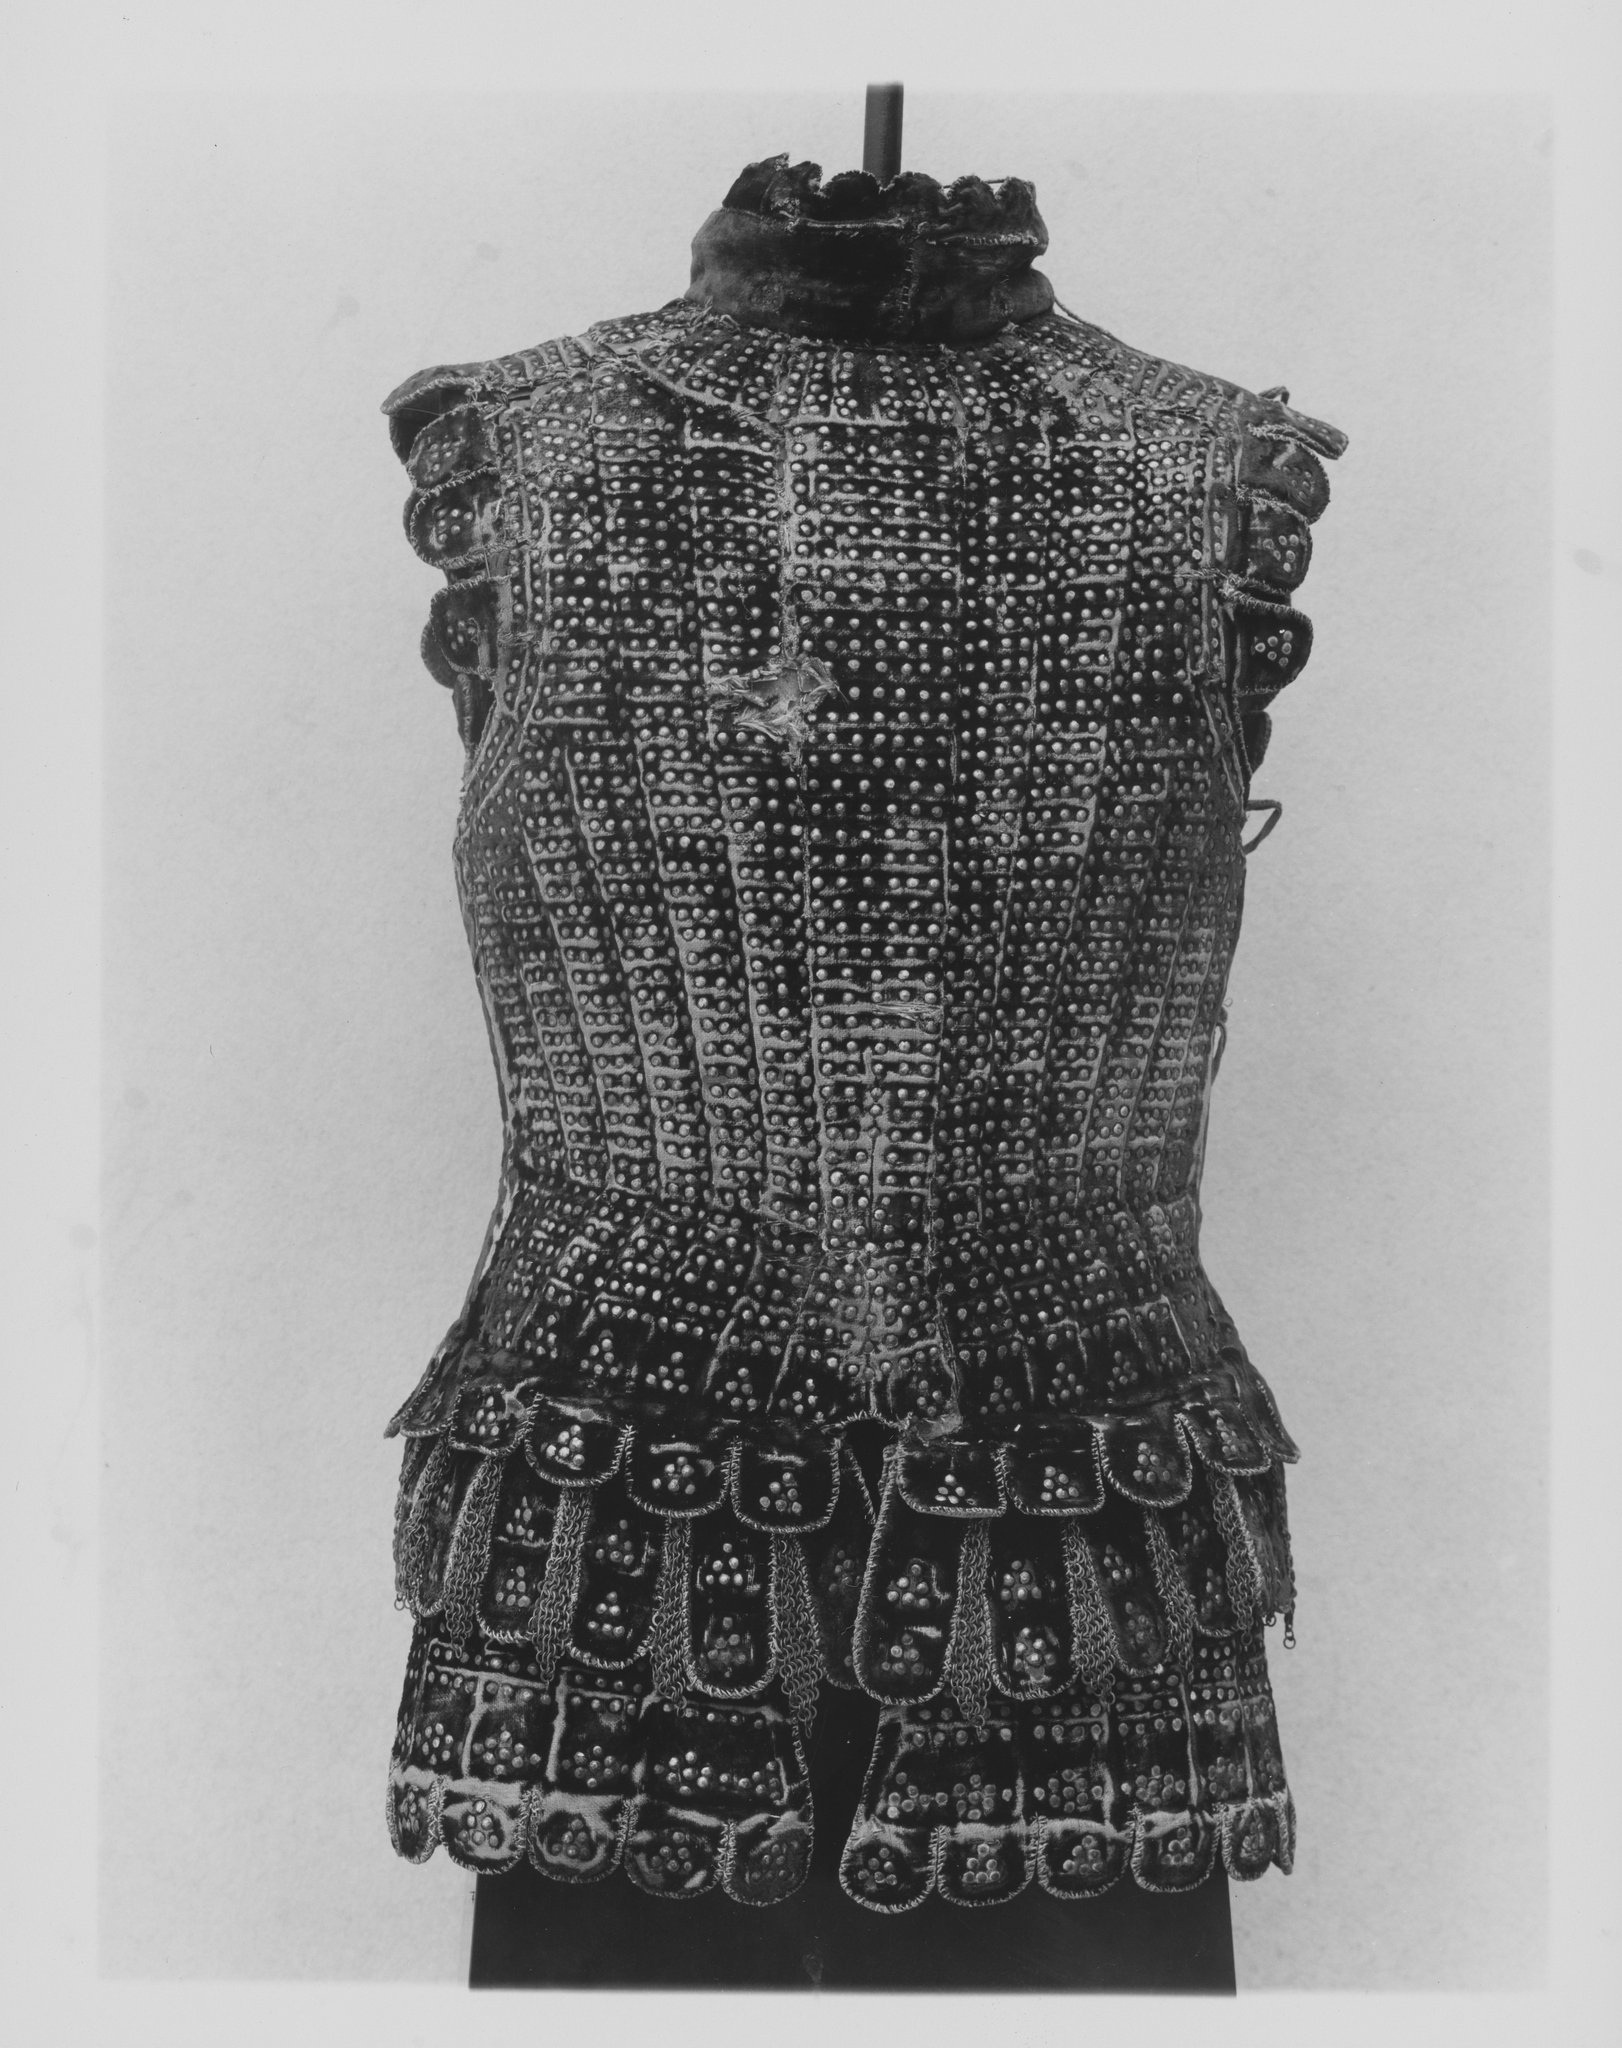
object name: brigandine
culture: italian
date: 1540-1550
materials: steel, textile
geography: italy